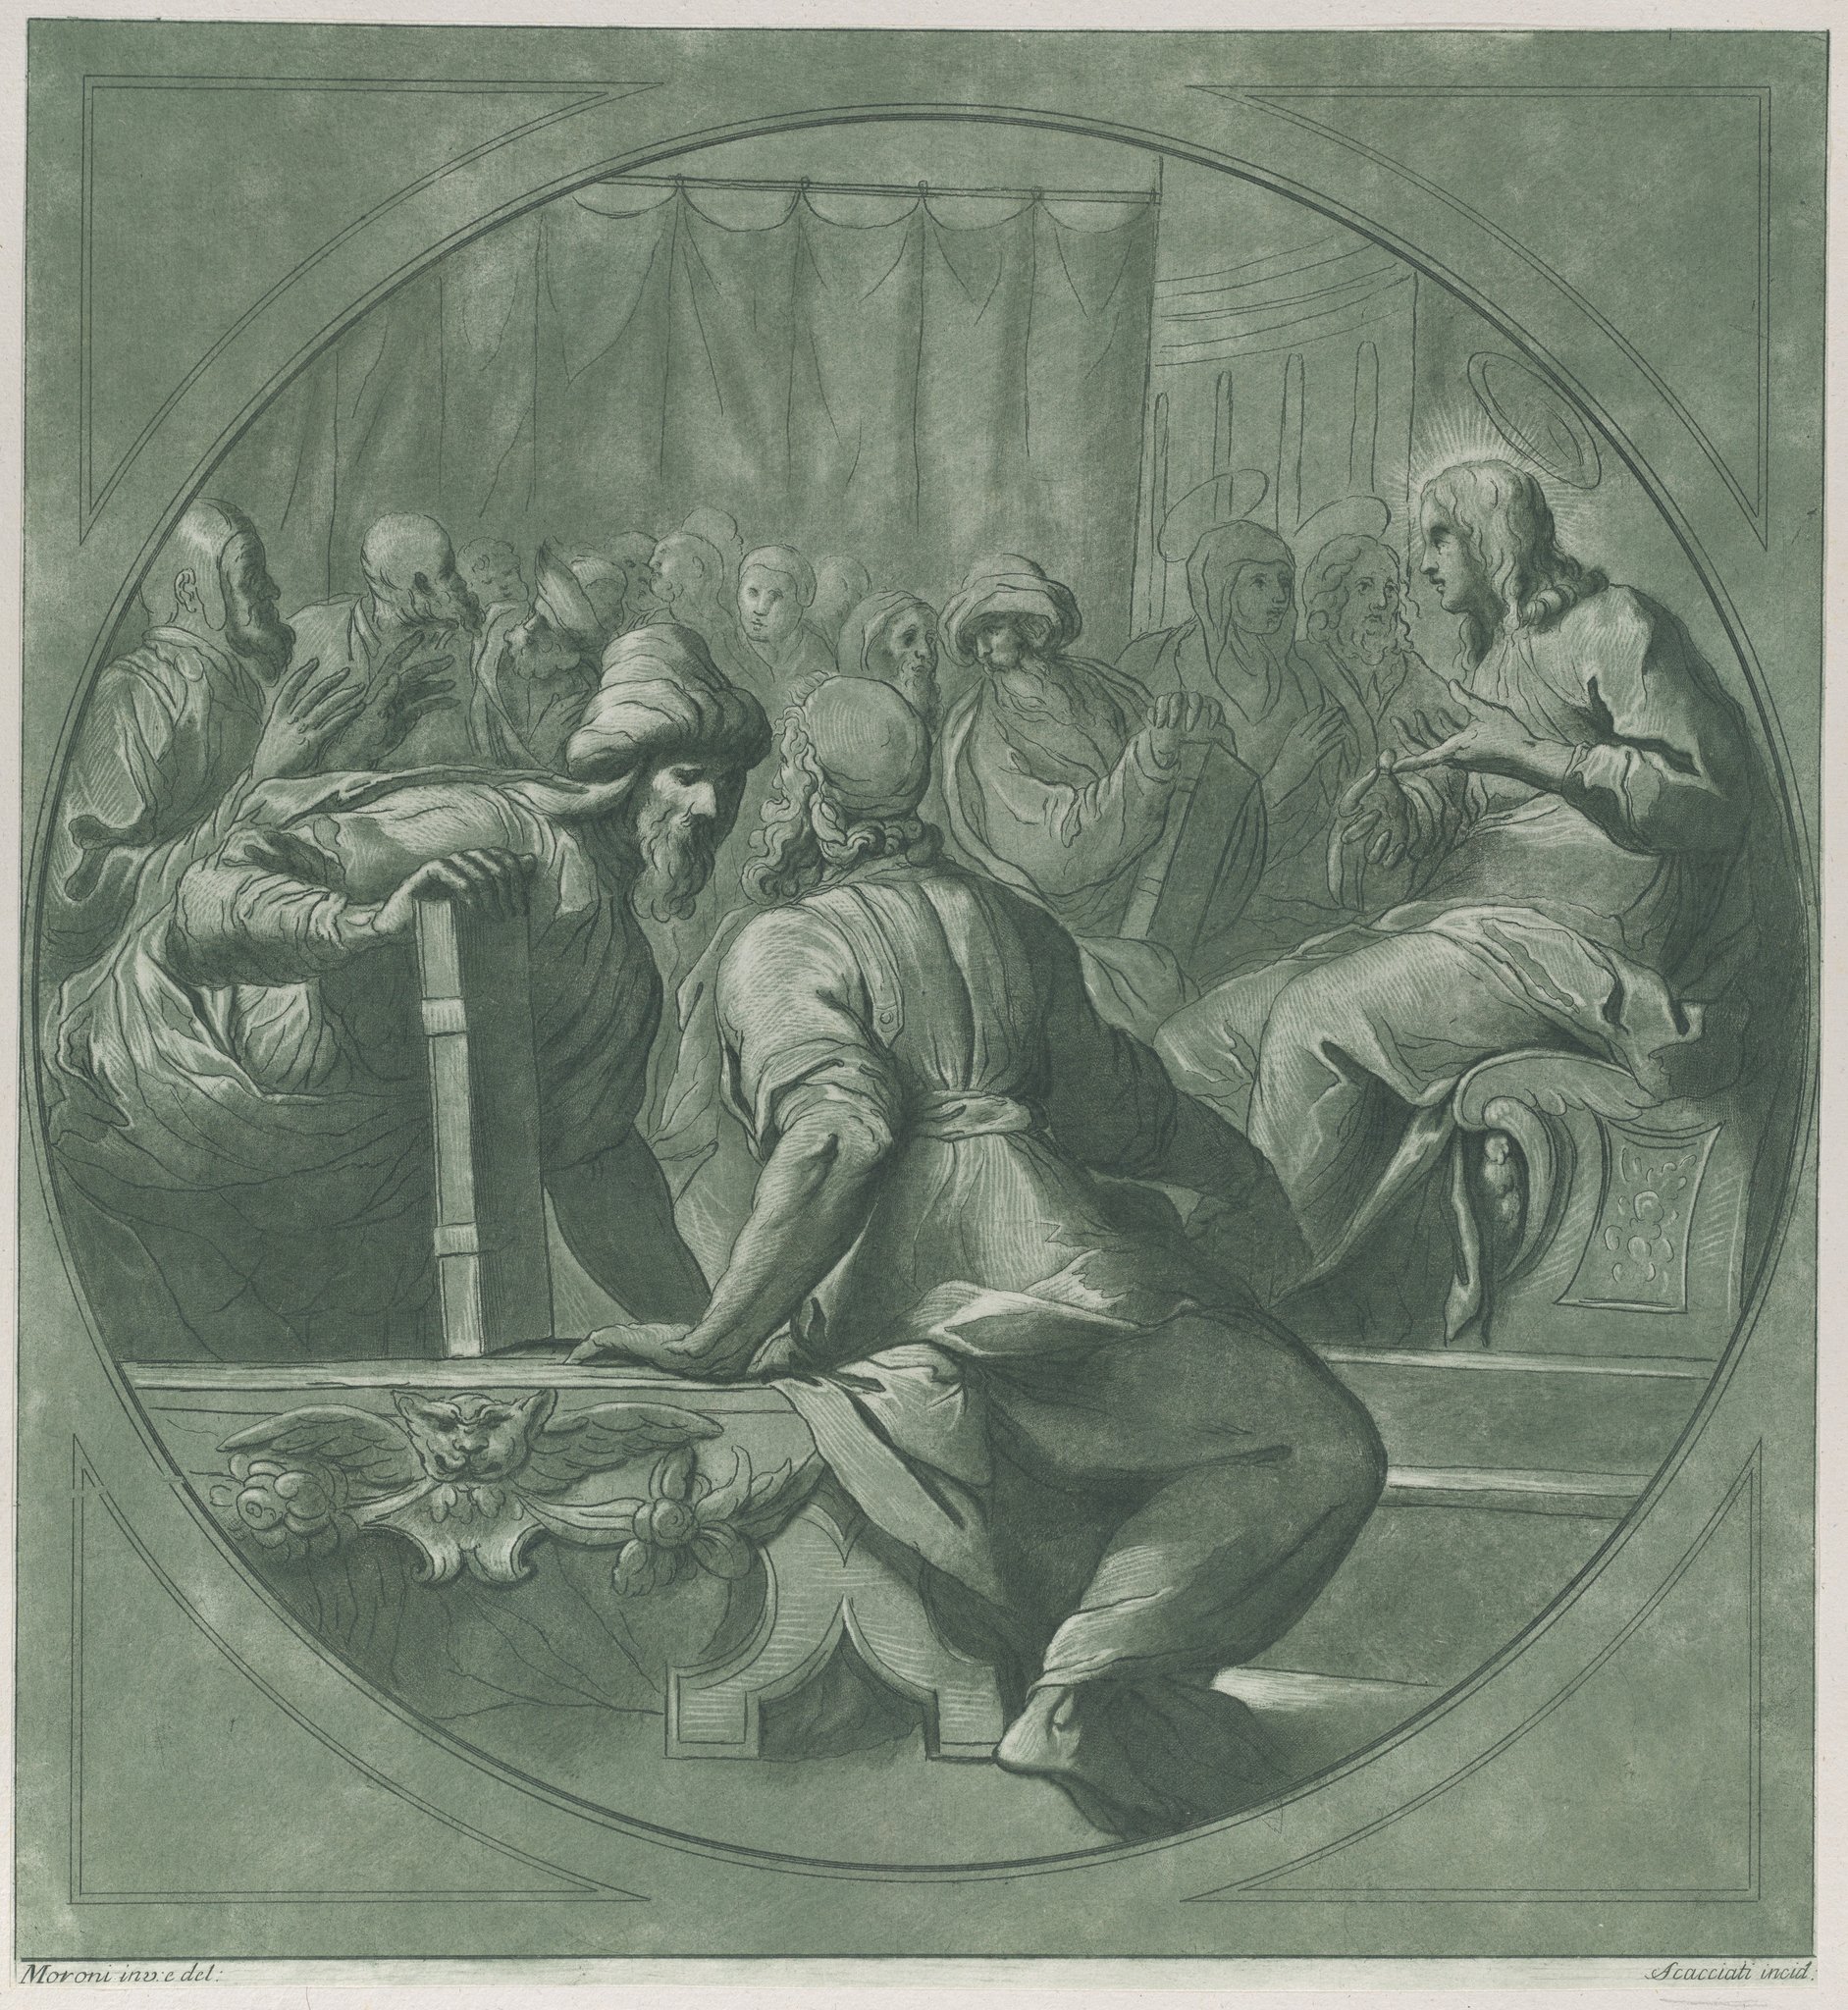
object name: print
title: Christ confounding the doctors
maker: andrea scacciati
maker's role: artist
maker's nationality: italian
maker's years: 1725-1771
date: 1750-1770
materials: ink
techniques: aquatint, etching